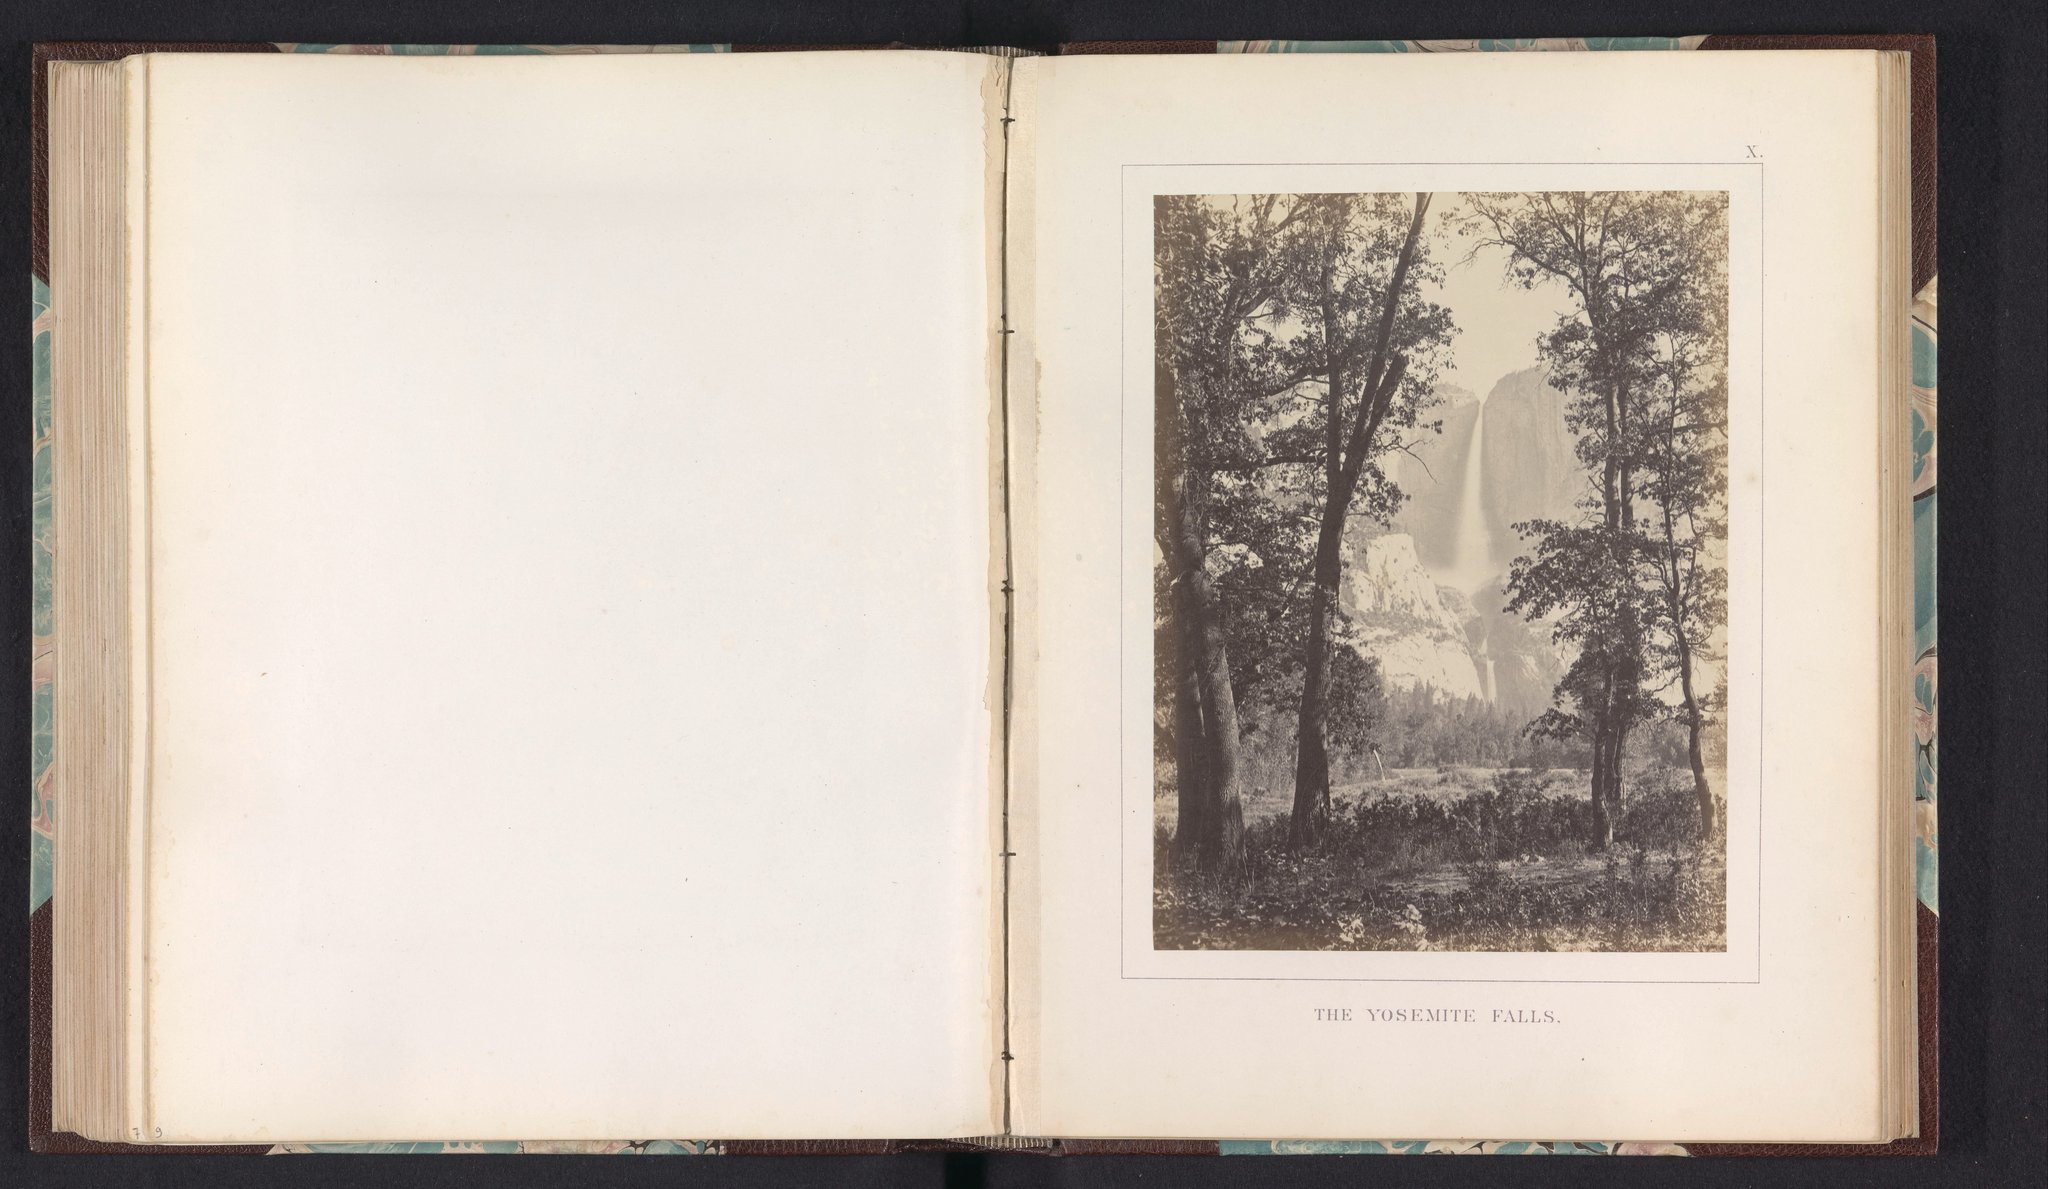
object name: photograph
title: The Yosemite Falls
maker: carleton e. watkins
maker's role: fotograaf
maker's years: 1829-1916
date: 1860-1868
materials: photographic support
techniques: albumen print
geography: yosemite valley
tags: dale, valley, waterfall, mountains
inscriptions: number: ‘X.’